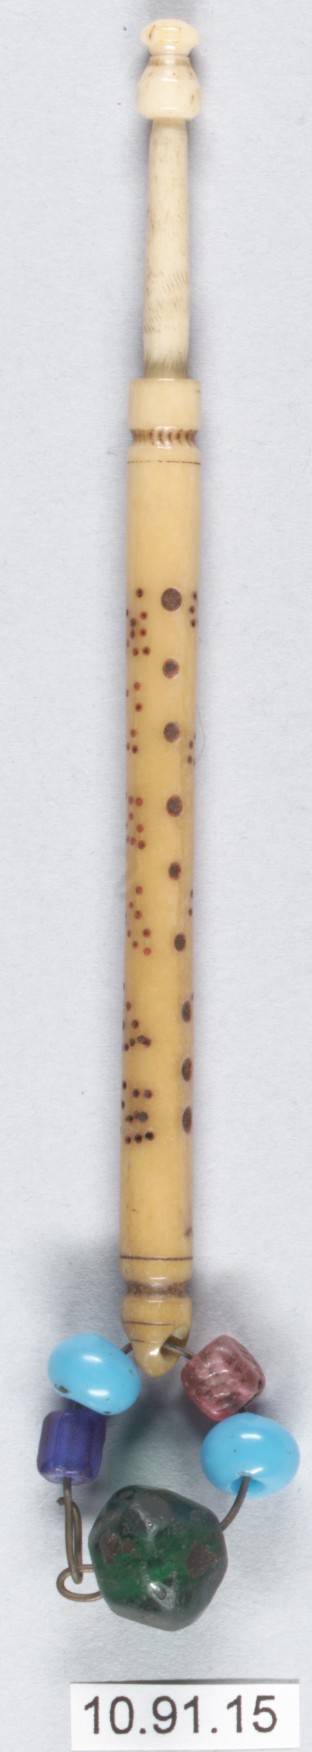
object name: bobbin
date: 1801-1900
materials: bone